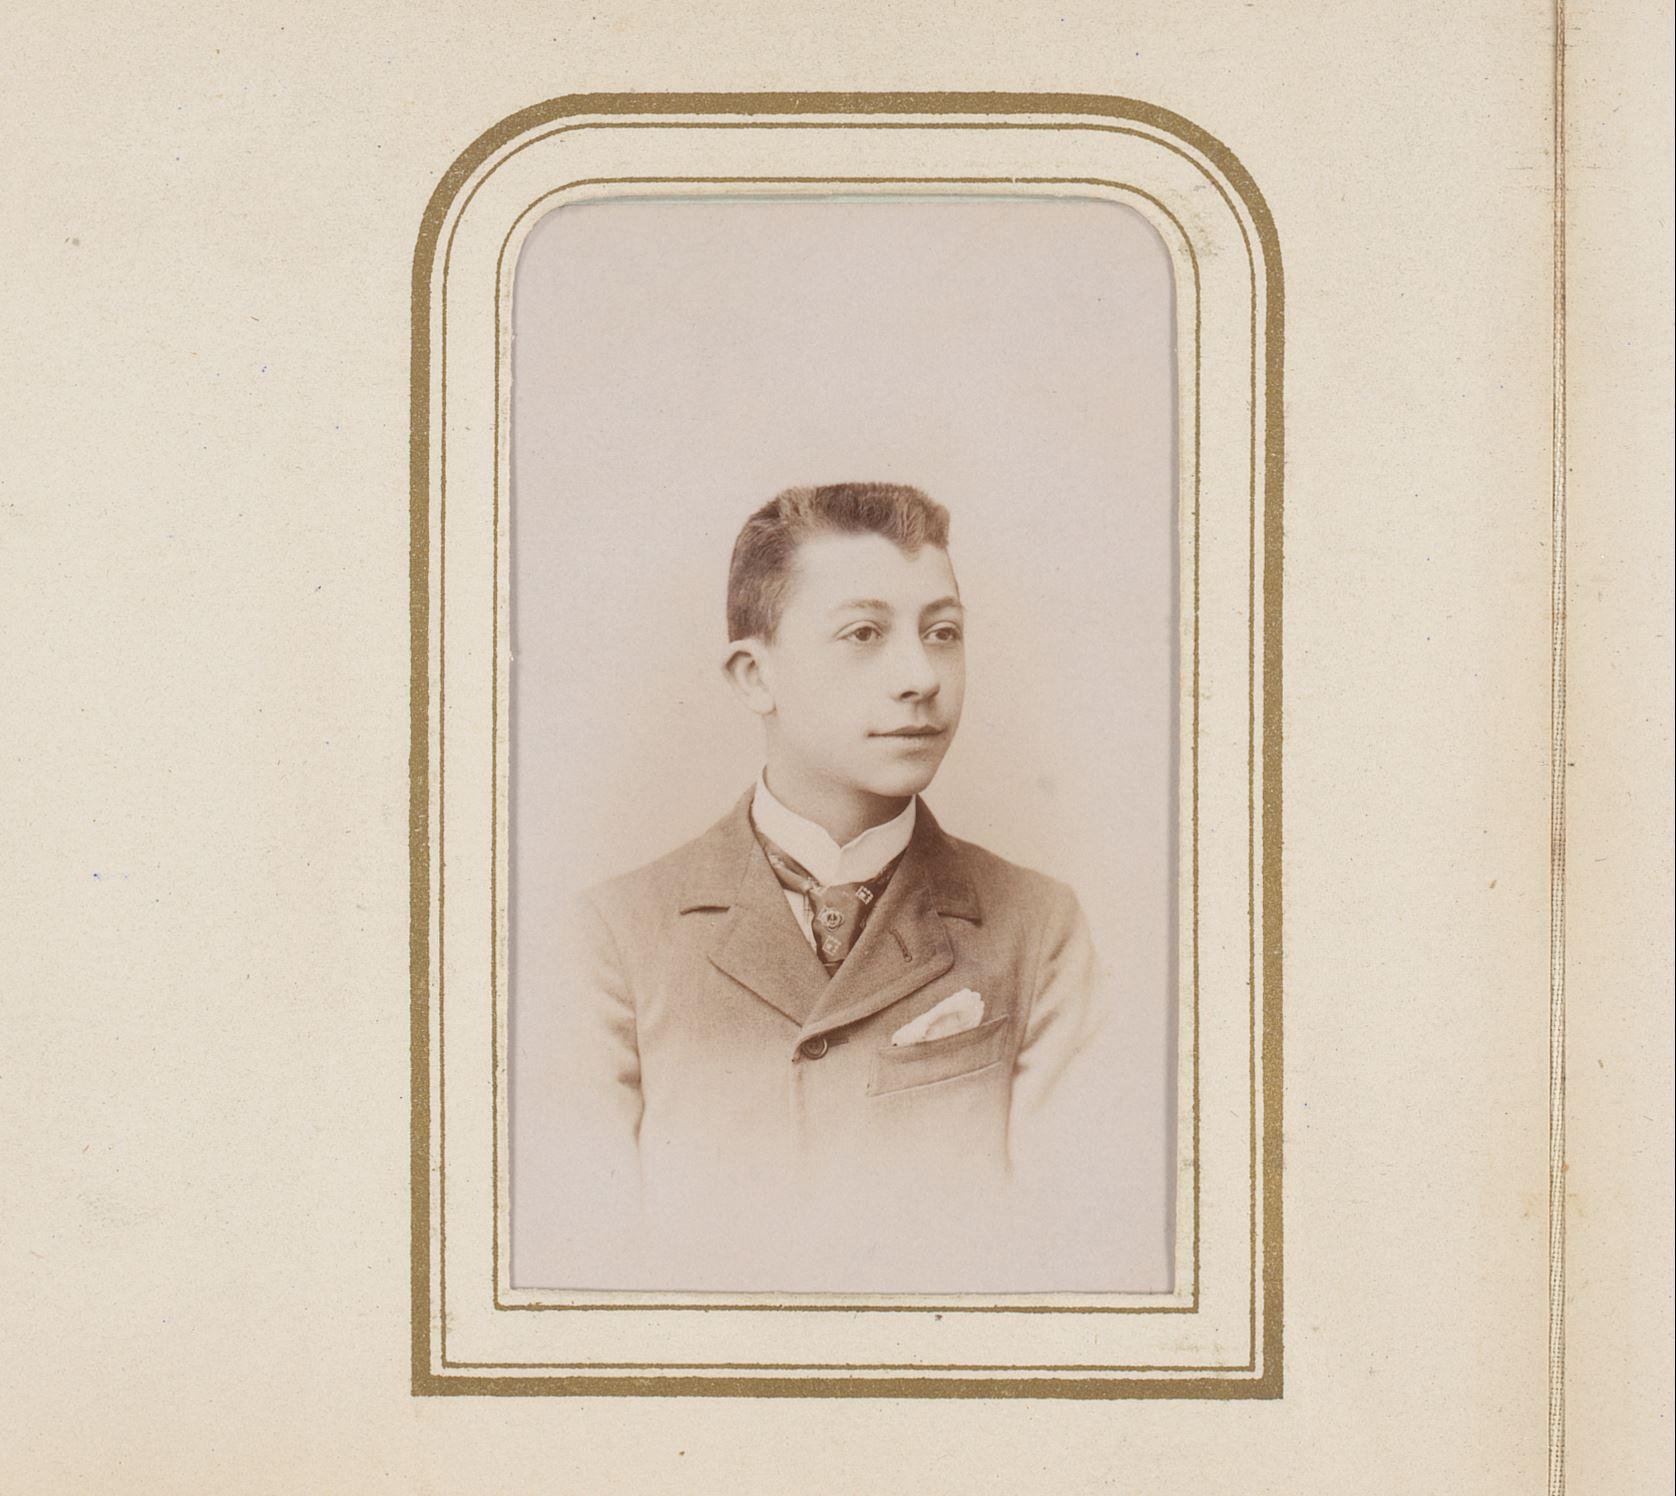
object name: carte de visite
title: Portret van een jongeman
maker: petrus monroche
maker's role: fotograaf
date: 1880-1920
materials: cardboard, photographic support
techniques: albumen print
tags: historical persons, youth, adolescent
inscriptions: inscription: ‘Phototgraphie/ la pointe Rivoli/ (...)/ Pétrus Monroché/ 110/ Rue St. Antoine/ Paris (...)’